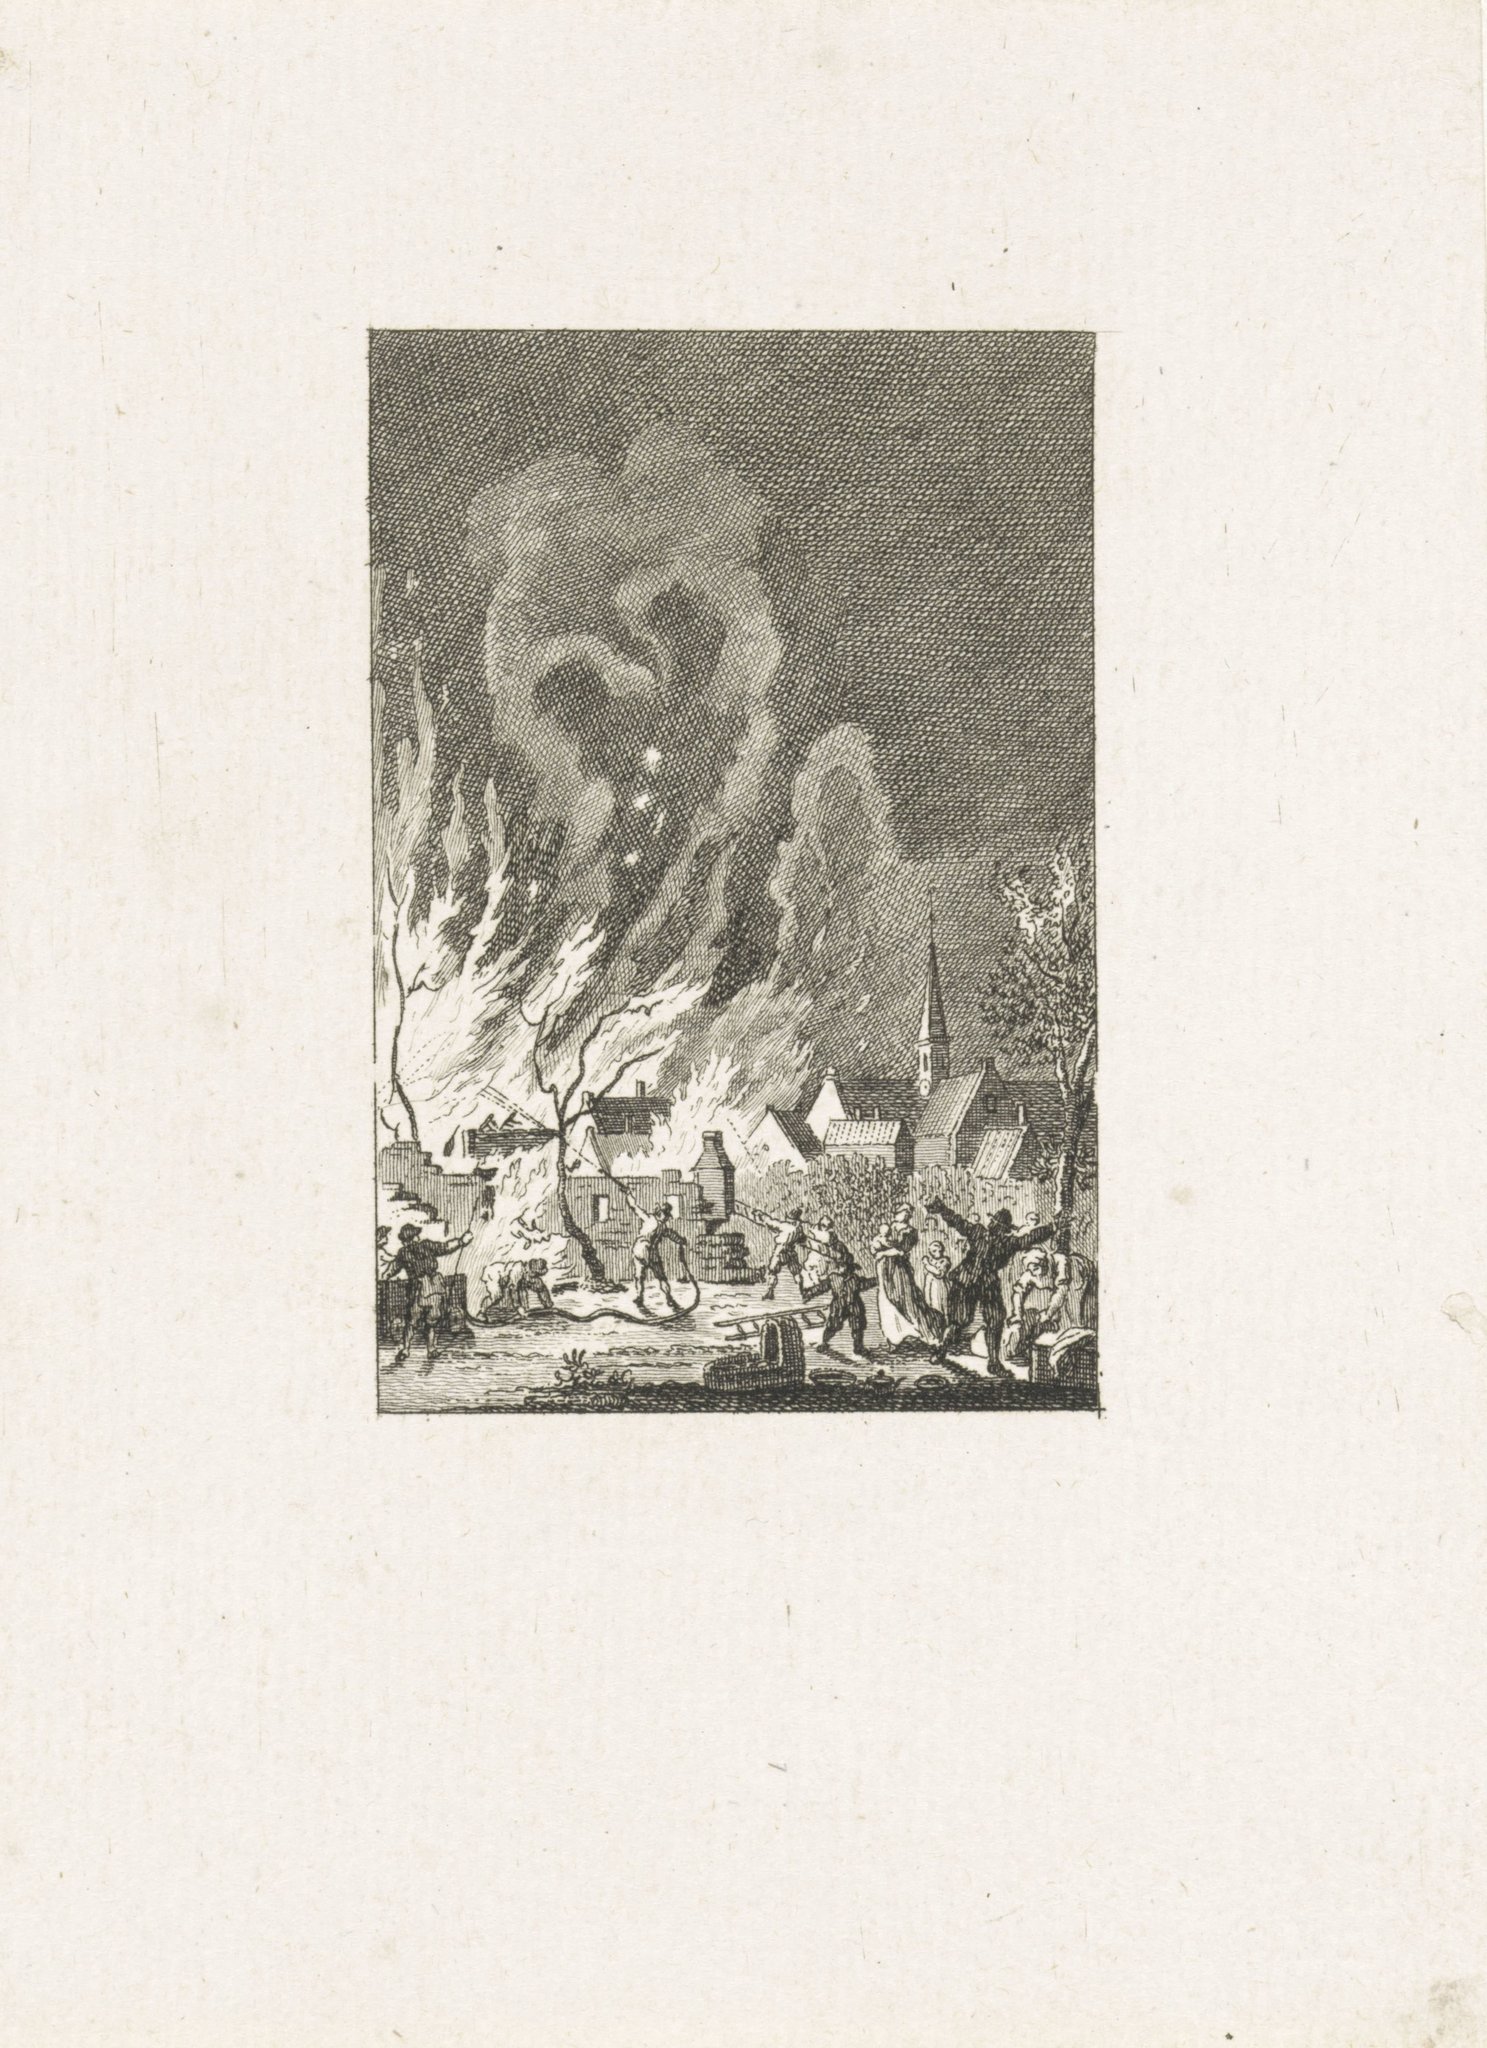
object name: print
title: Brand te Amstelveen, 1792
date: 1792-1795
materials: paper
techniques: etching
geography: northern netherlands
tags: on fire, ablaze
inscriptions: collector's mark: Lugt 2228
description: Gebruikt als illustratie in: J. Fokke, Geschiedenissen der Vereenigde Nederlanden voor de vaderlandsche jeugd, Johannes Allart, Amsterdam 1783-1795, 25 delen, dl. 23, pl. 10.